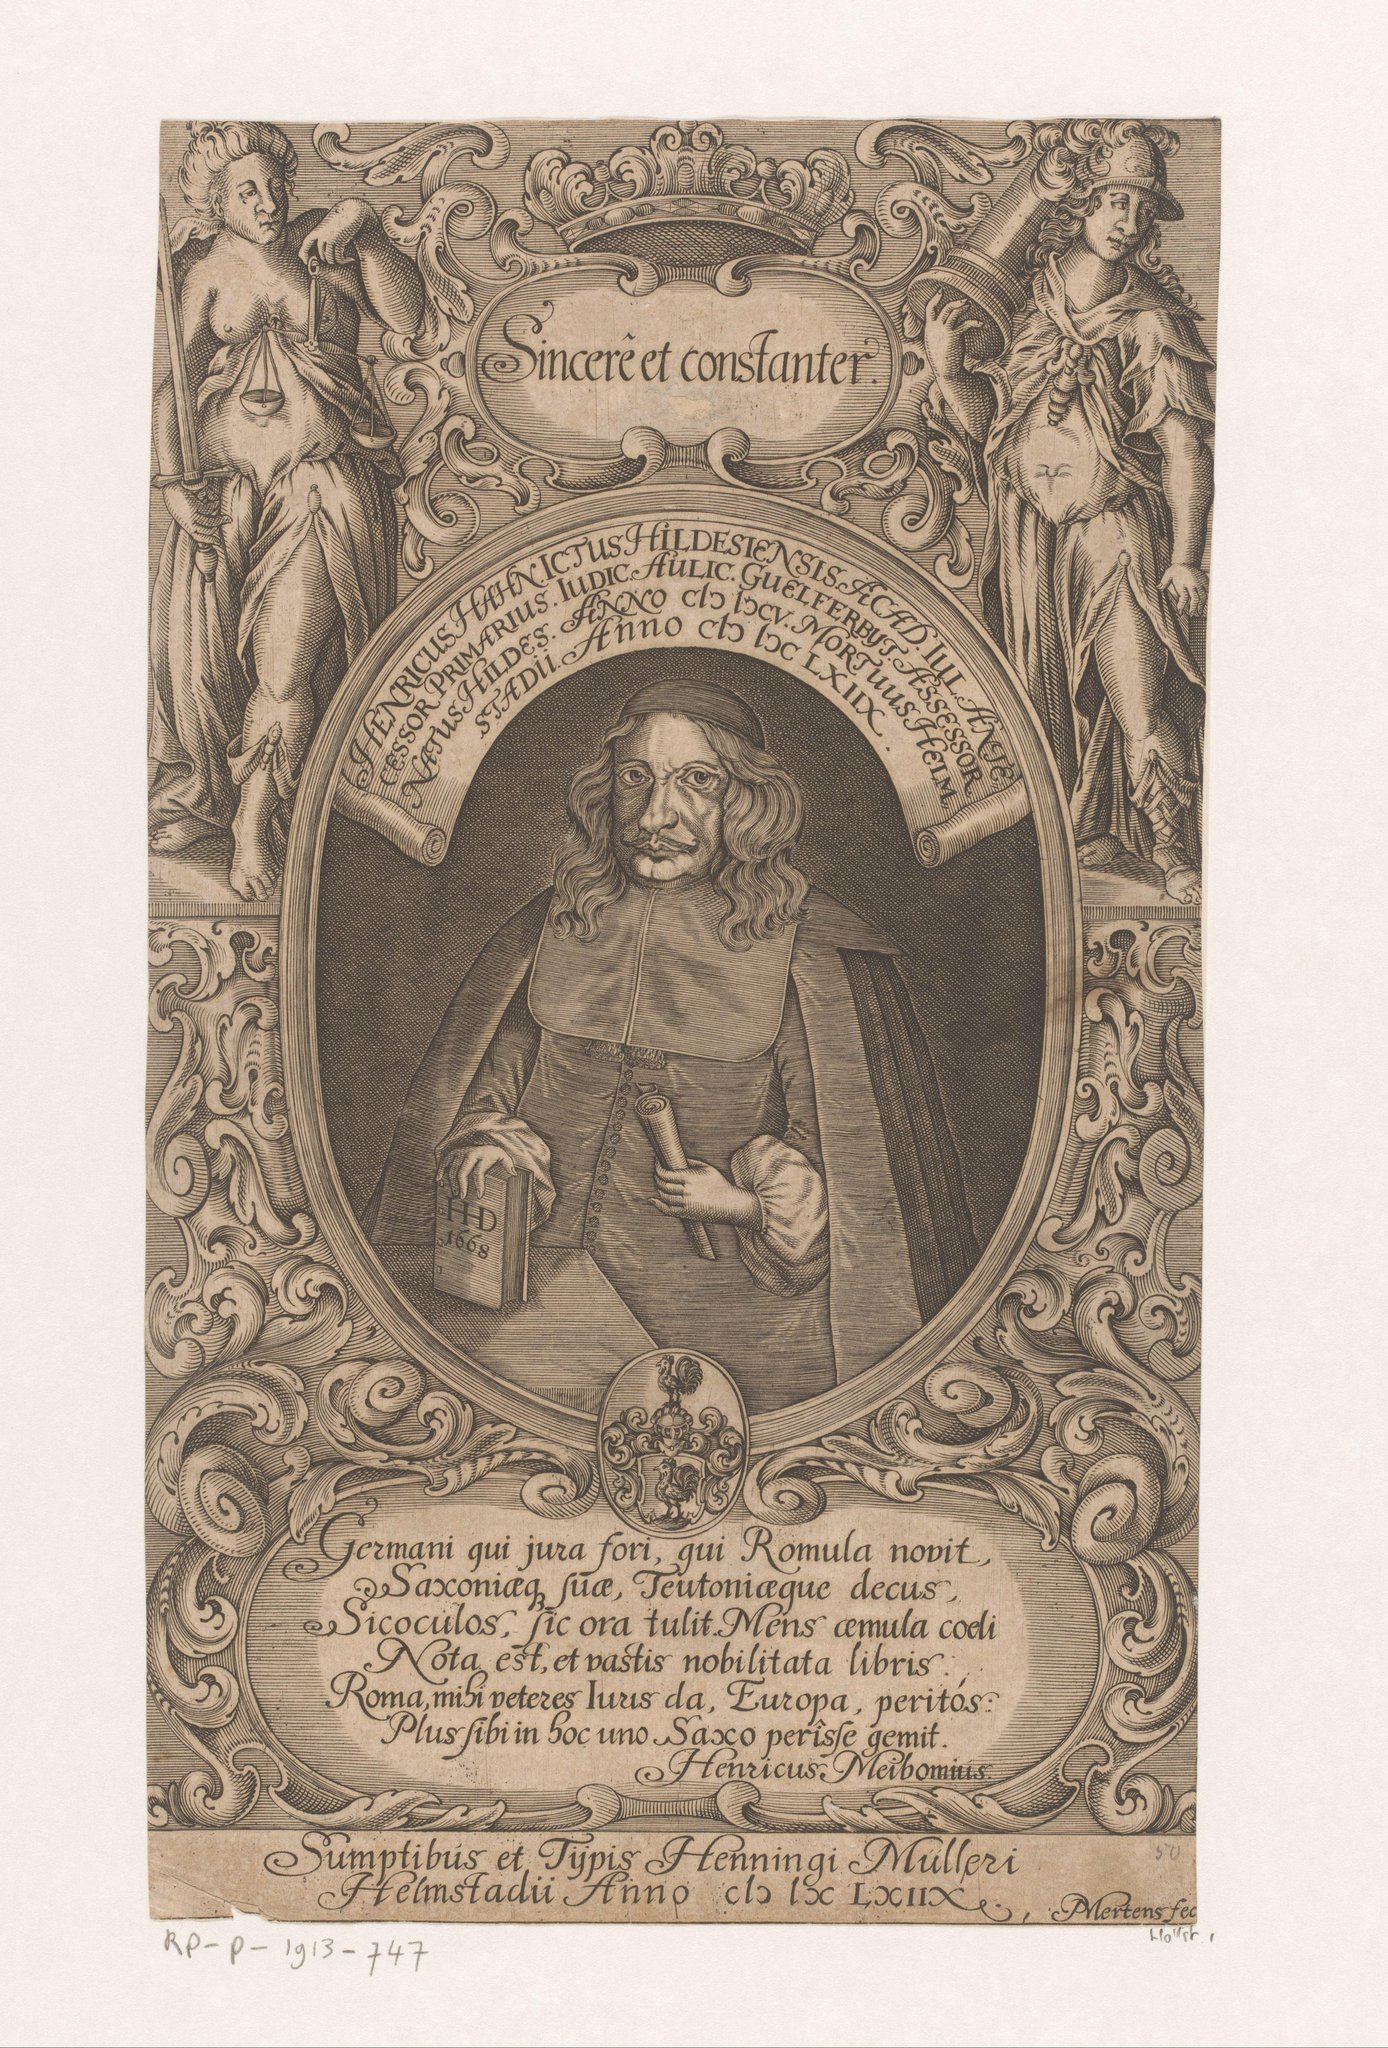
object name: print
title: Portret van Hendrich Hahn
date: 1668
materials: paper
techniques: engraving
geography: helmstedt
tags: scroll - ll - scroll unfolded, historical persons, justitia (justice) as roman personification, book, attributes of mars, armorial bearing, heraldry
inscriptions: collector's mark: Lugt 2228